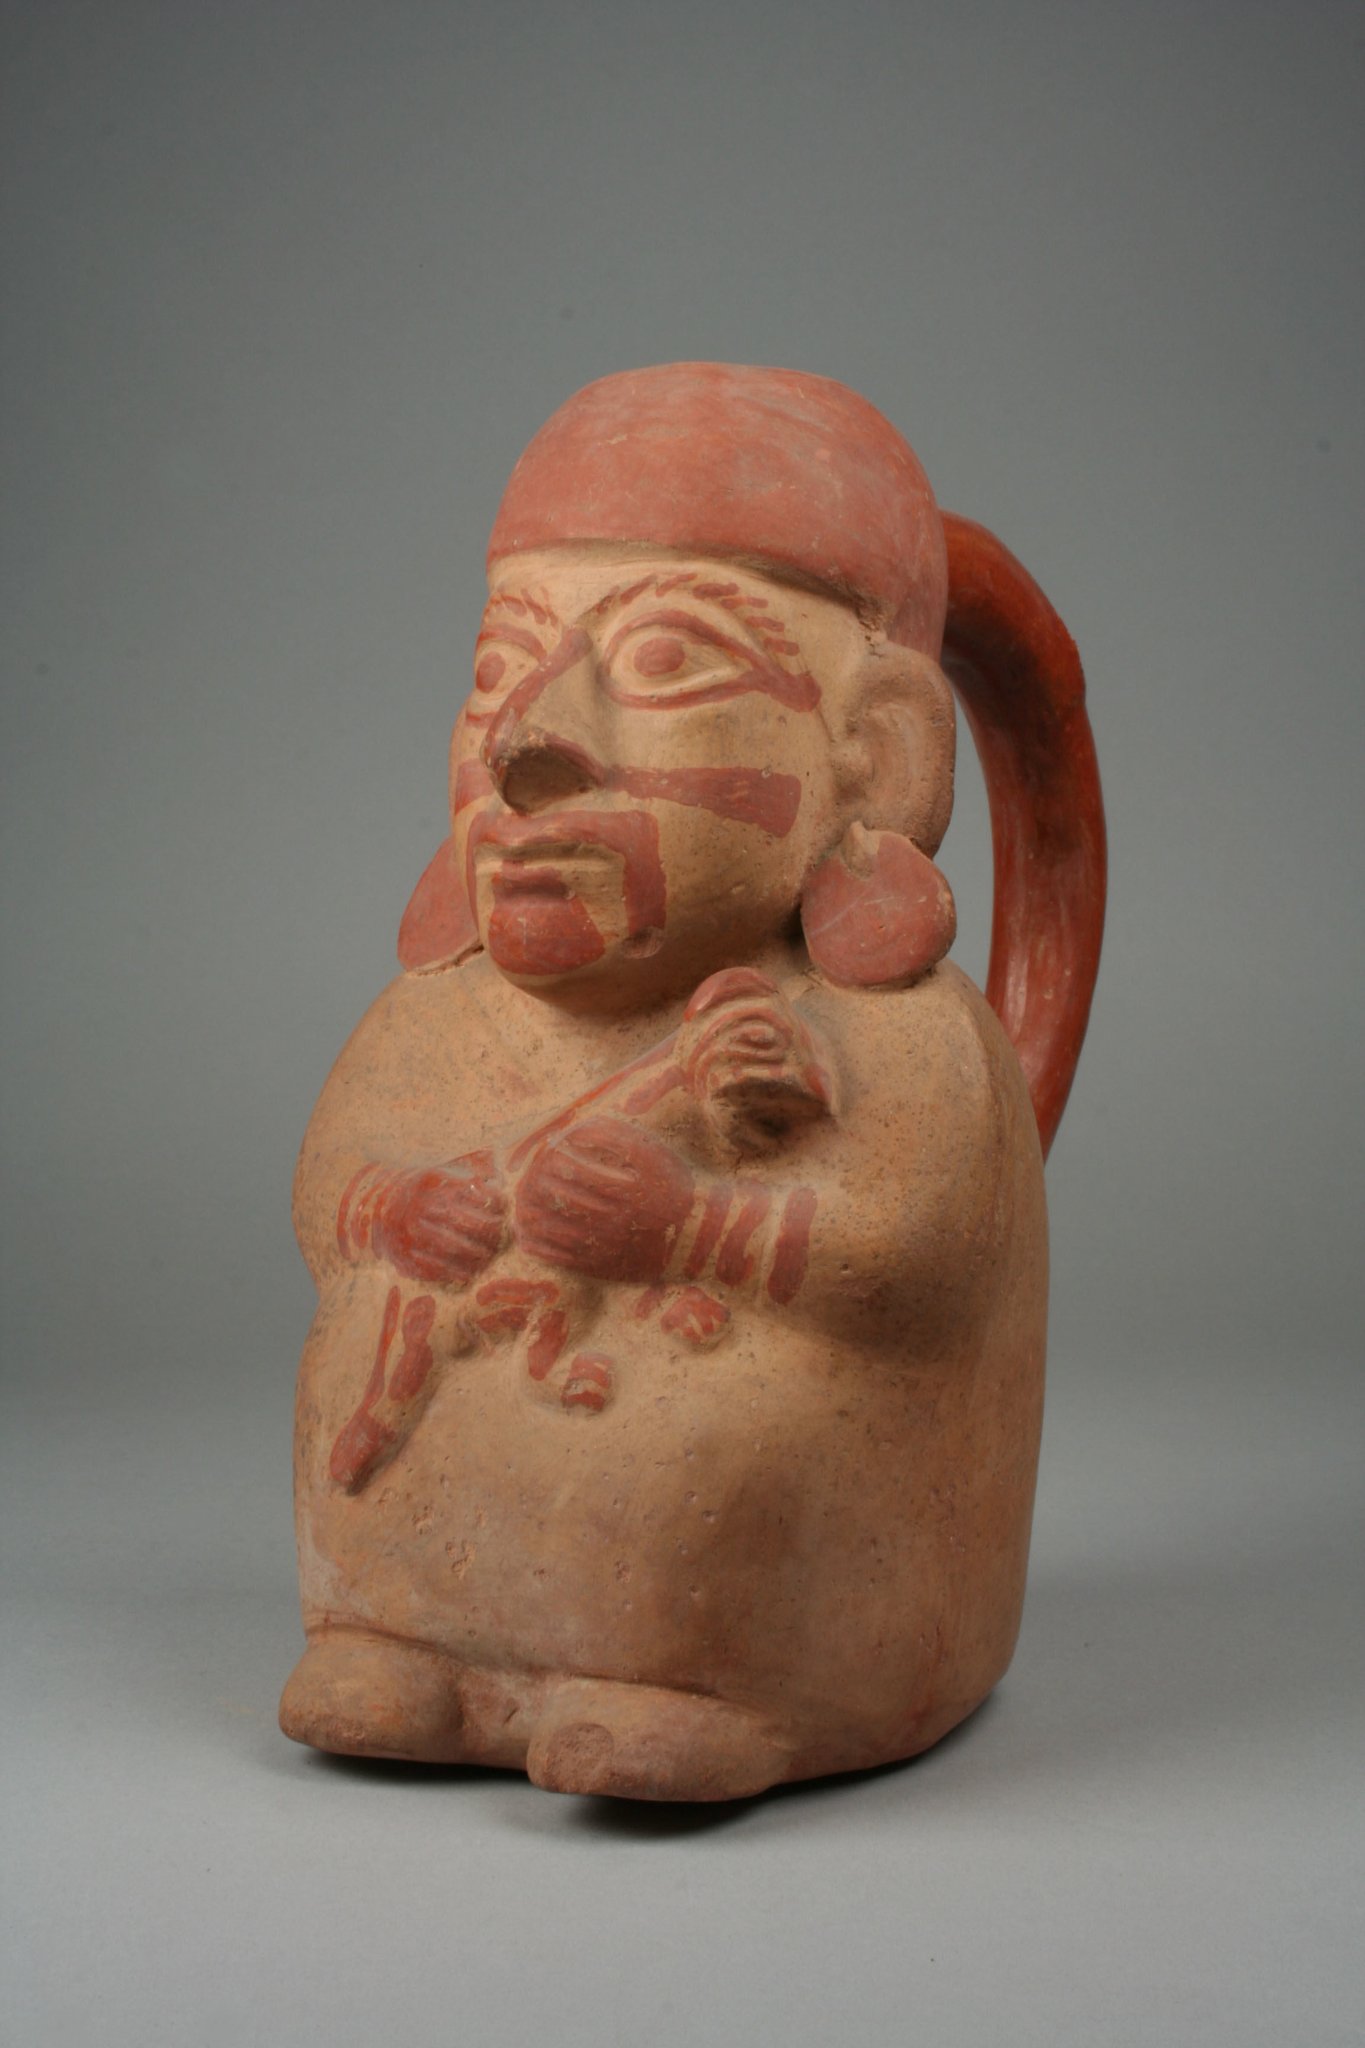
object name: bottle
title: Stirrup Spout Bottle with Figure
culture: moche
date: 401-700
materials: ceramic, pigment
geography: peru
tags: human figures,animals